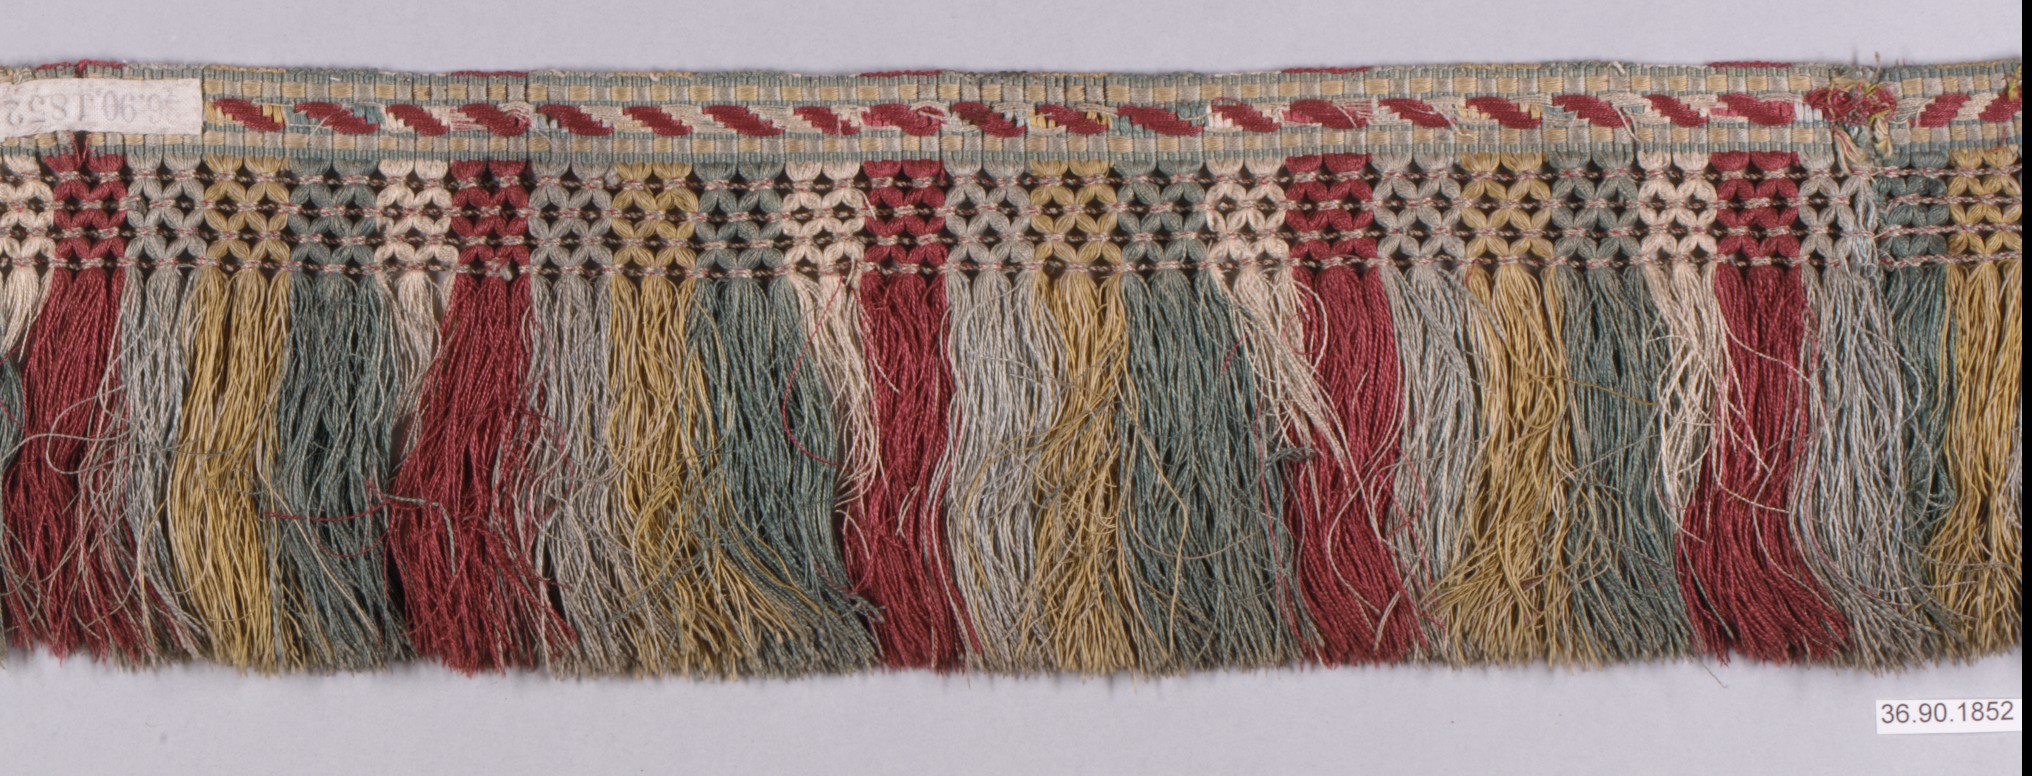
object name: fringe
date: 1801-1833